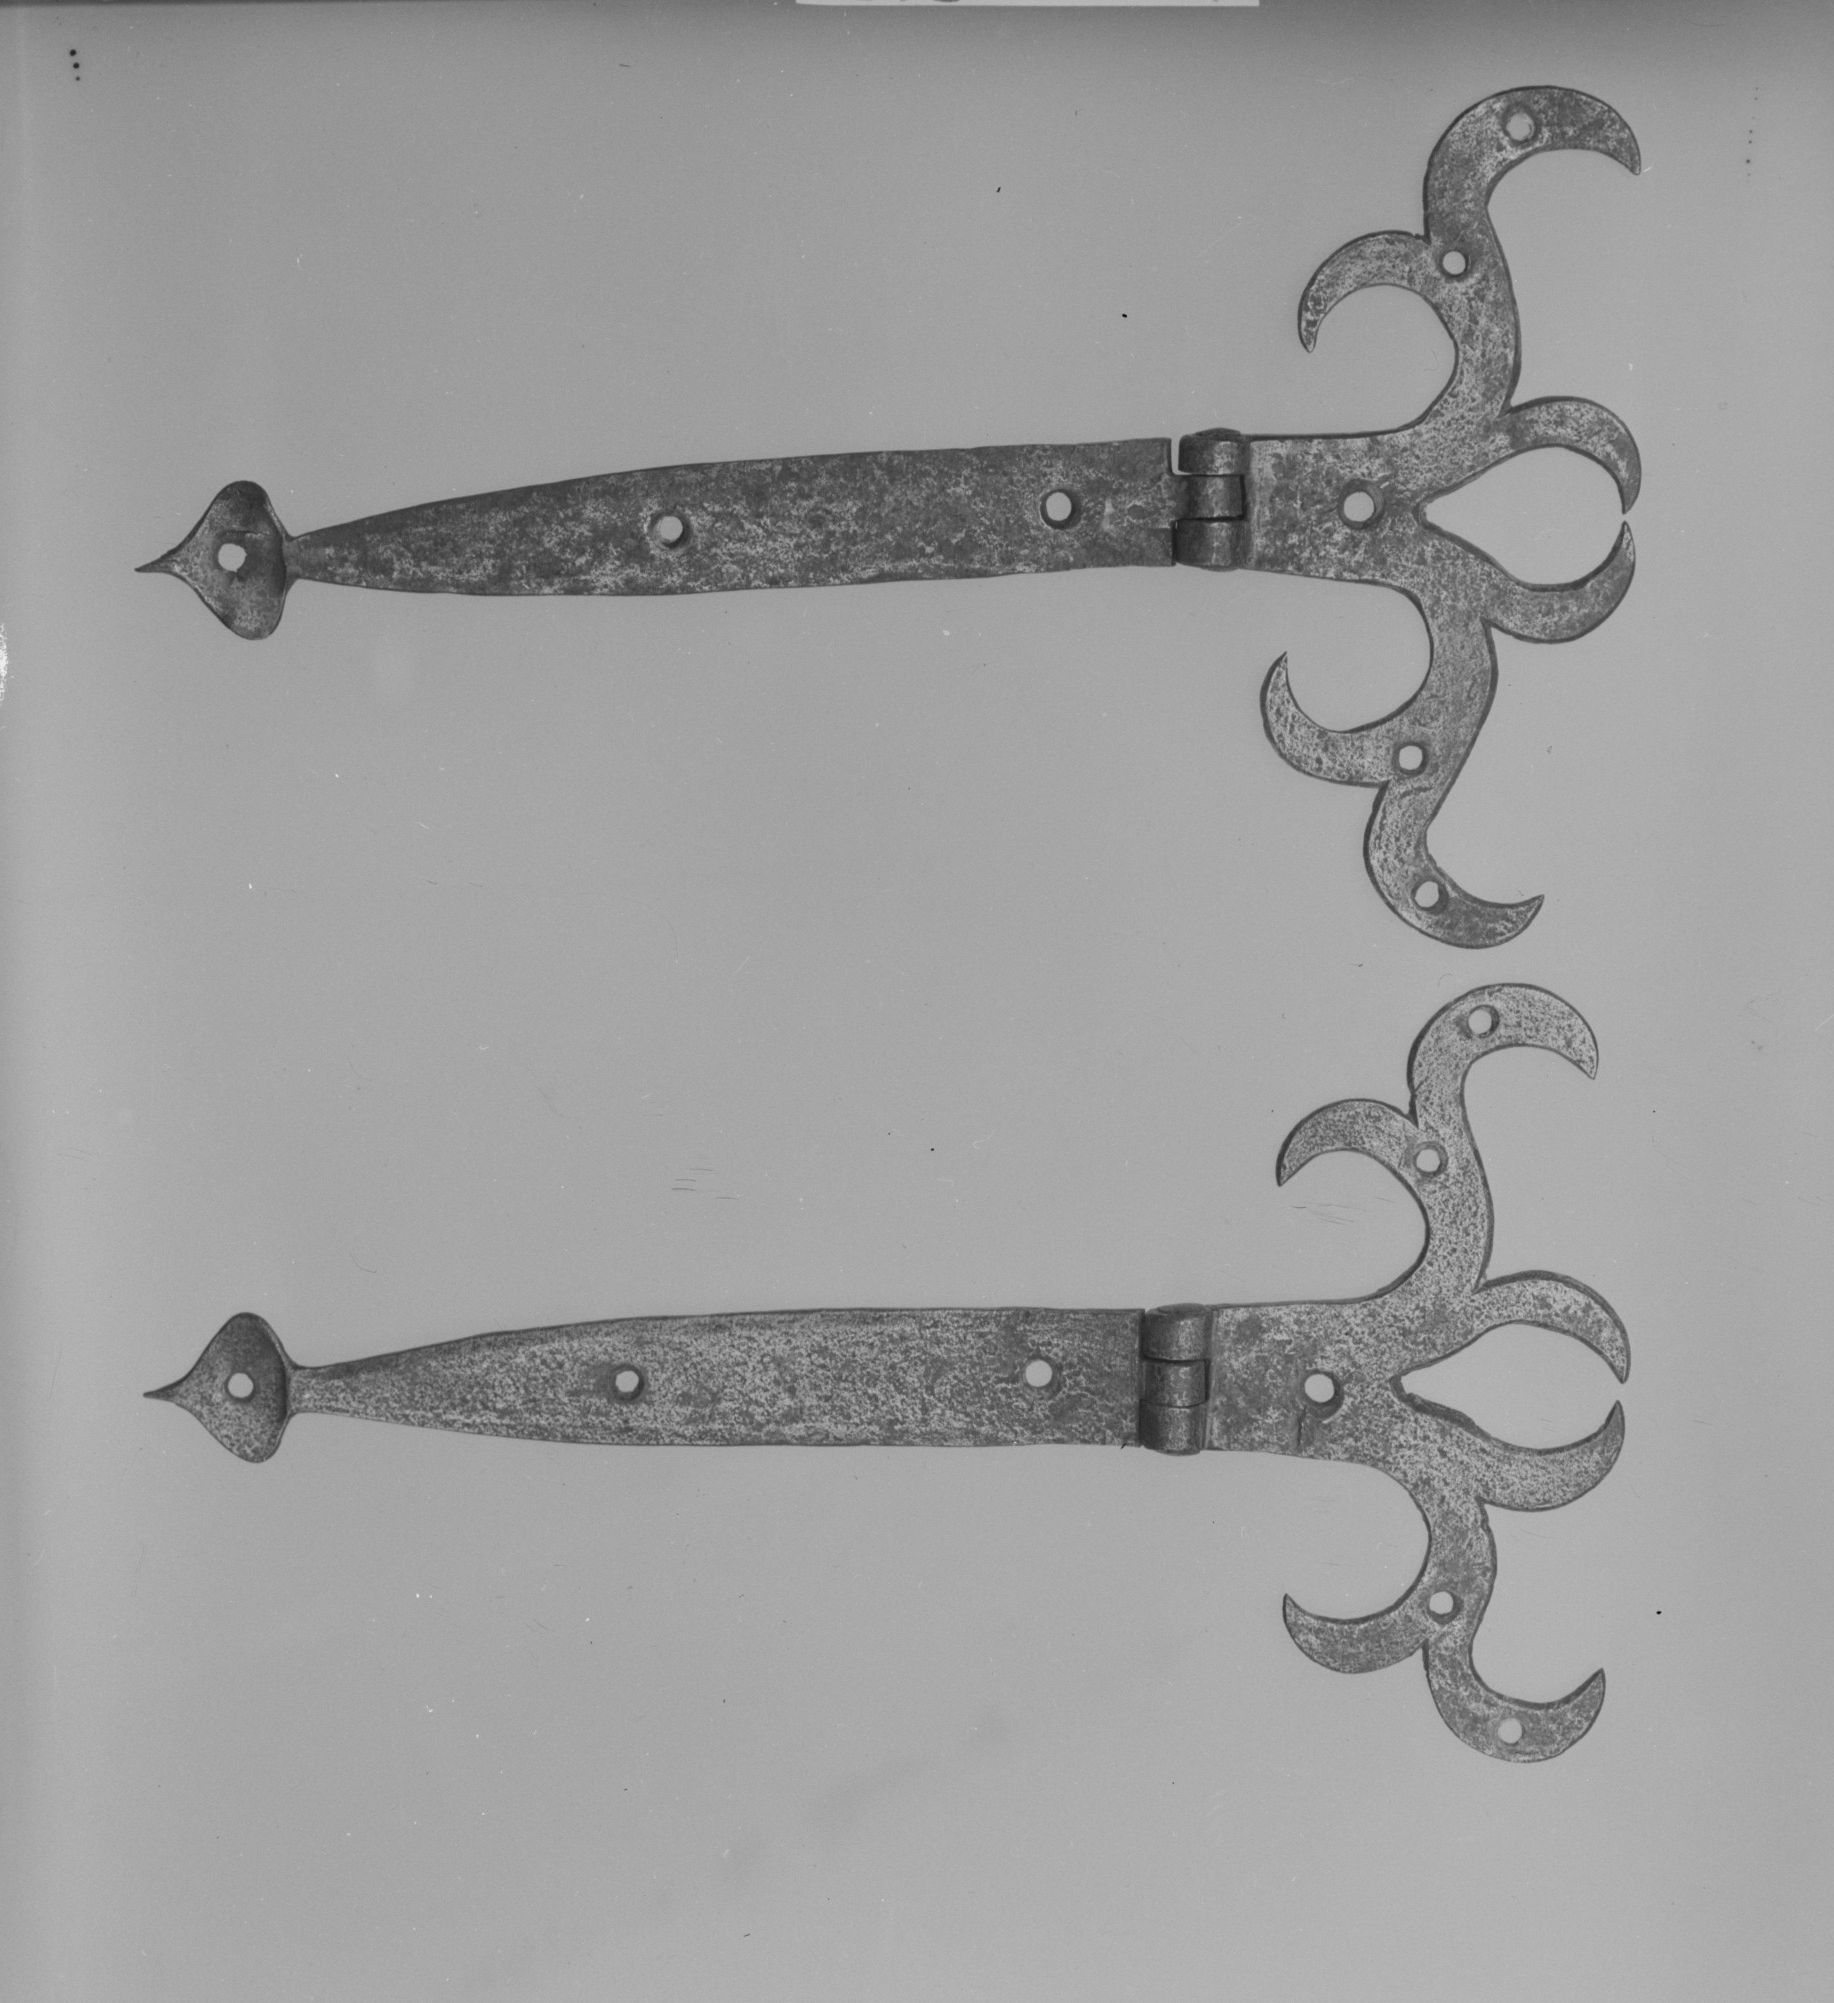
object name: hinge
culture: american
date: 1700-1800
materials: iron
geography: united states